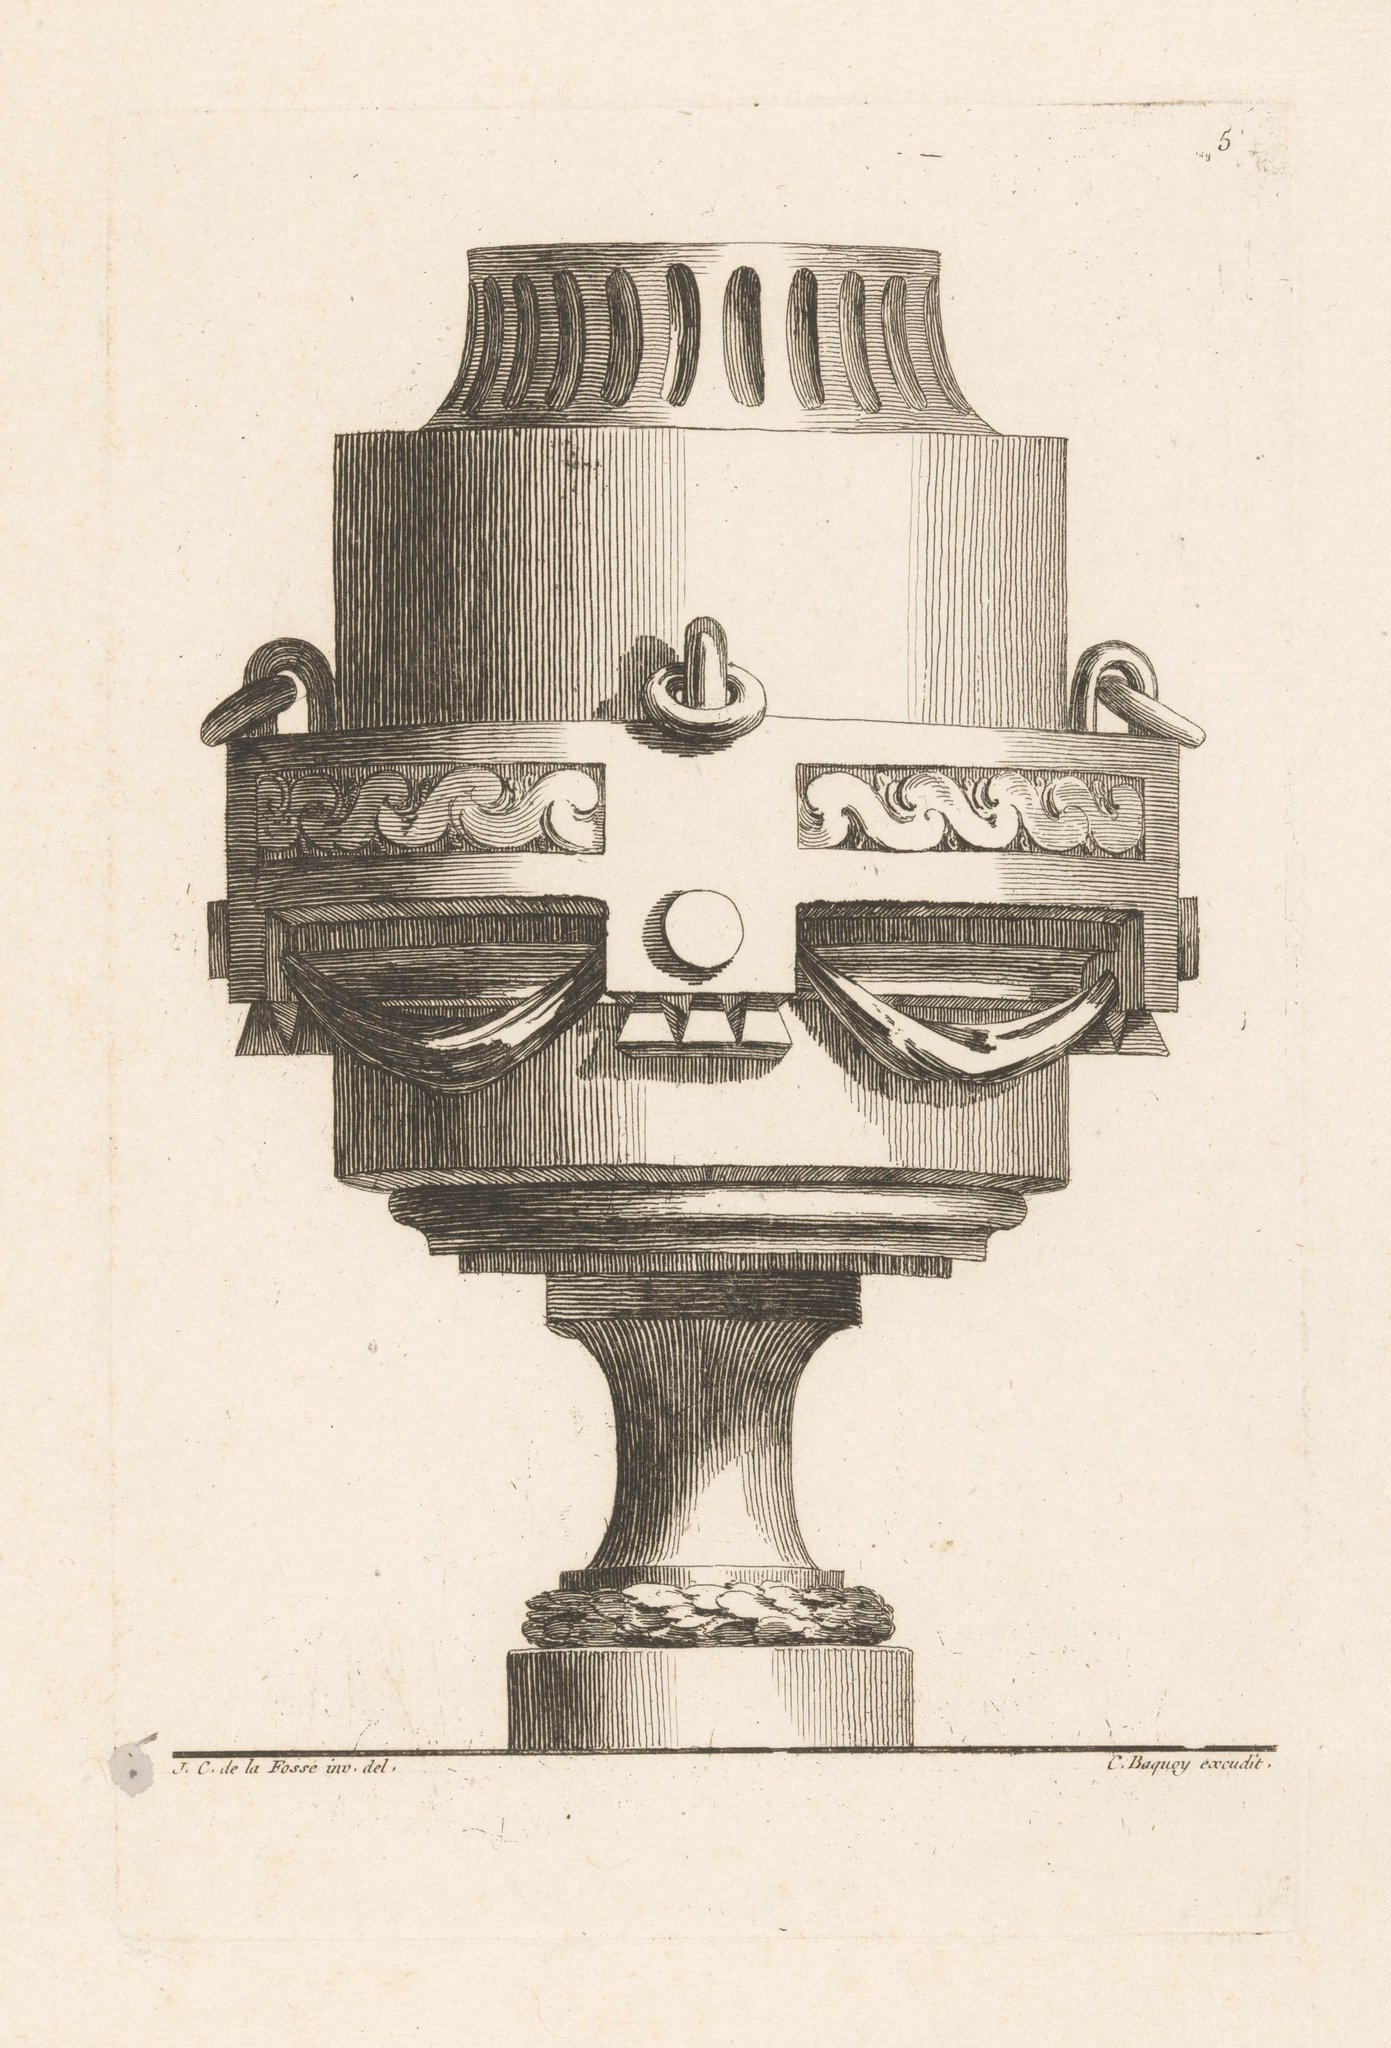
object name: ornament print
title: V Vases antiques. Cahier V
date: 1771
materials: paper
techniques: engraving, etching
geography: paris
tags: vase ~ ornament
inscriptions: collector's mark: Lugt 2760, collector's mark: Lugt 2228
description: Een geornamenteerde vaas met ringen en draperieën.